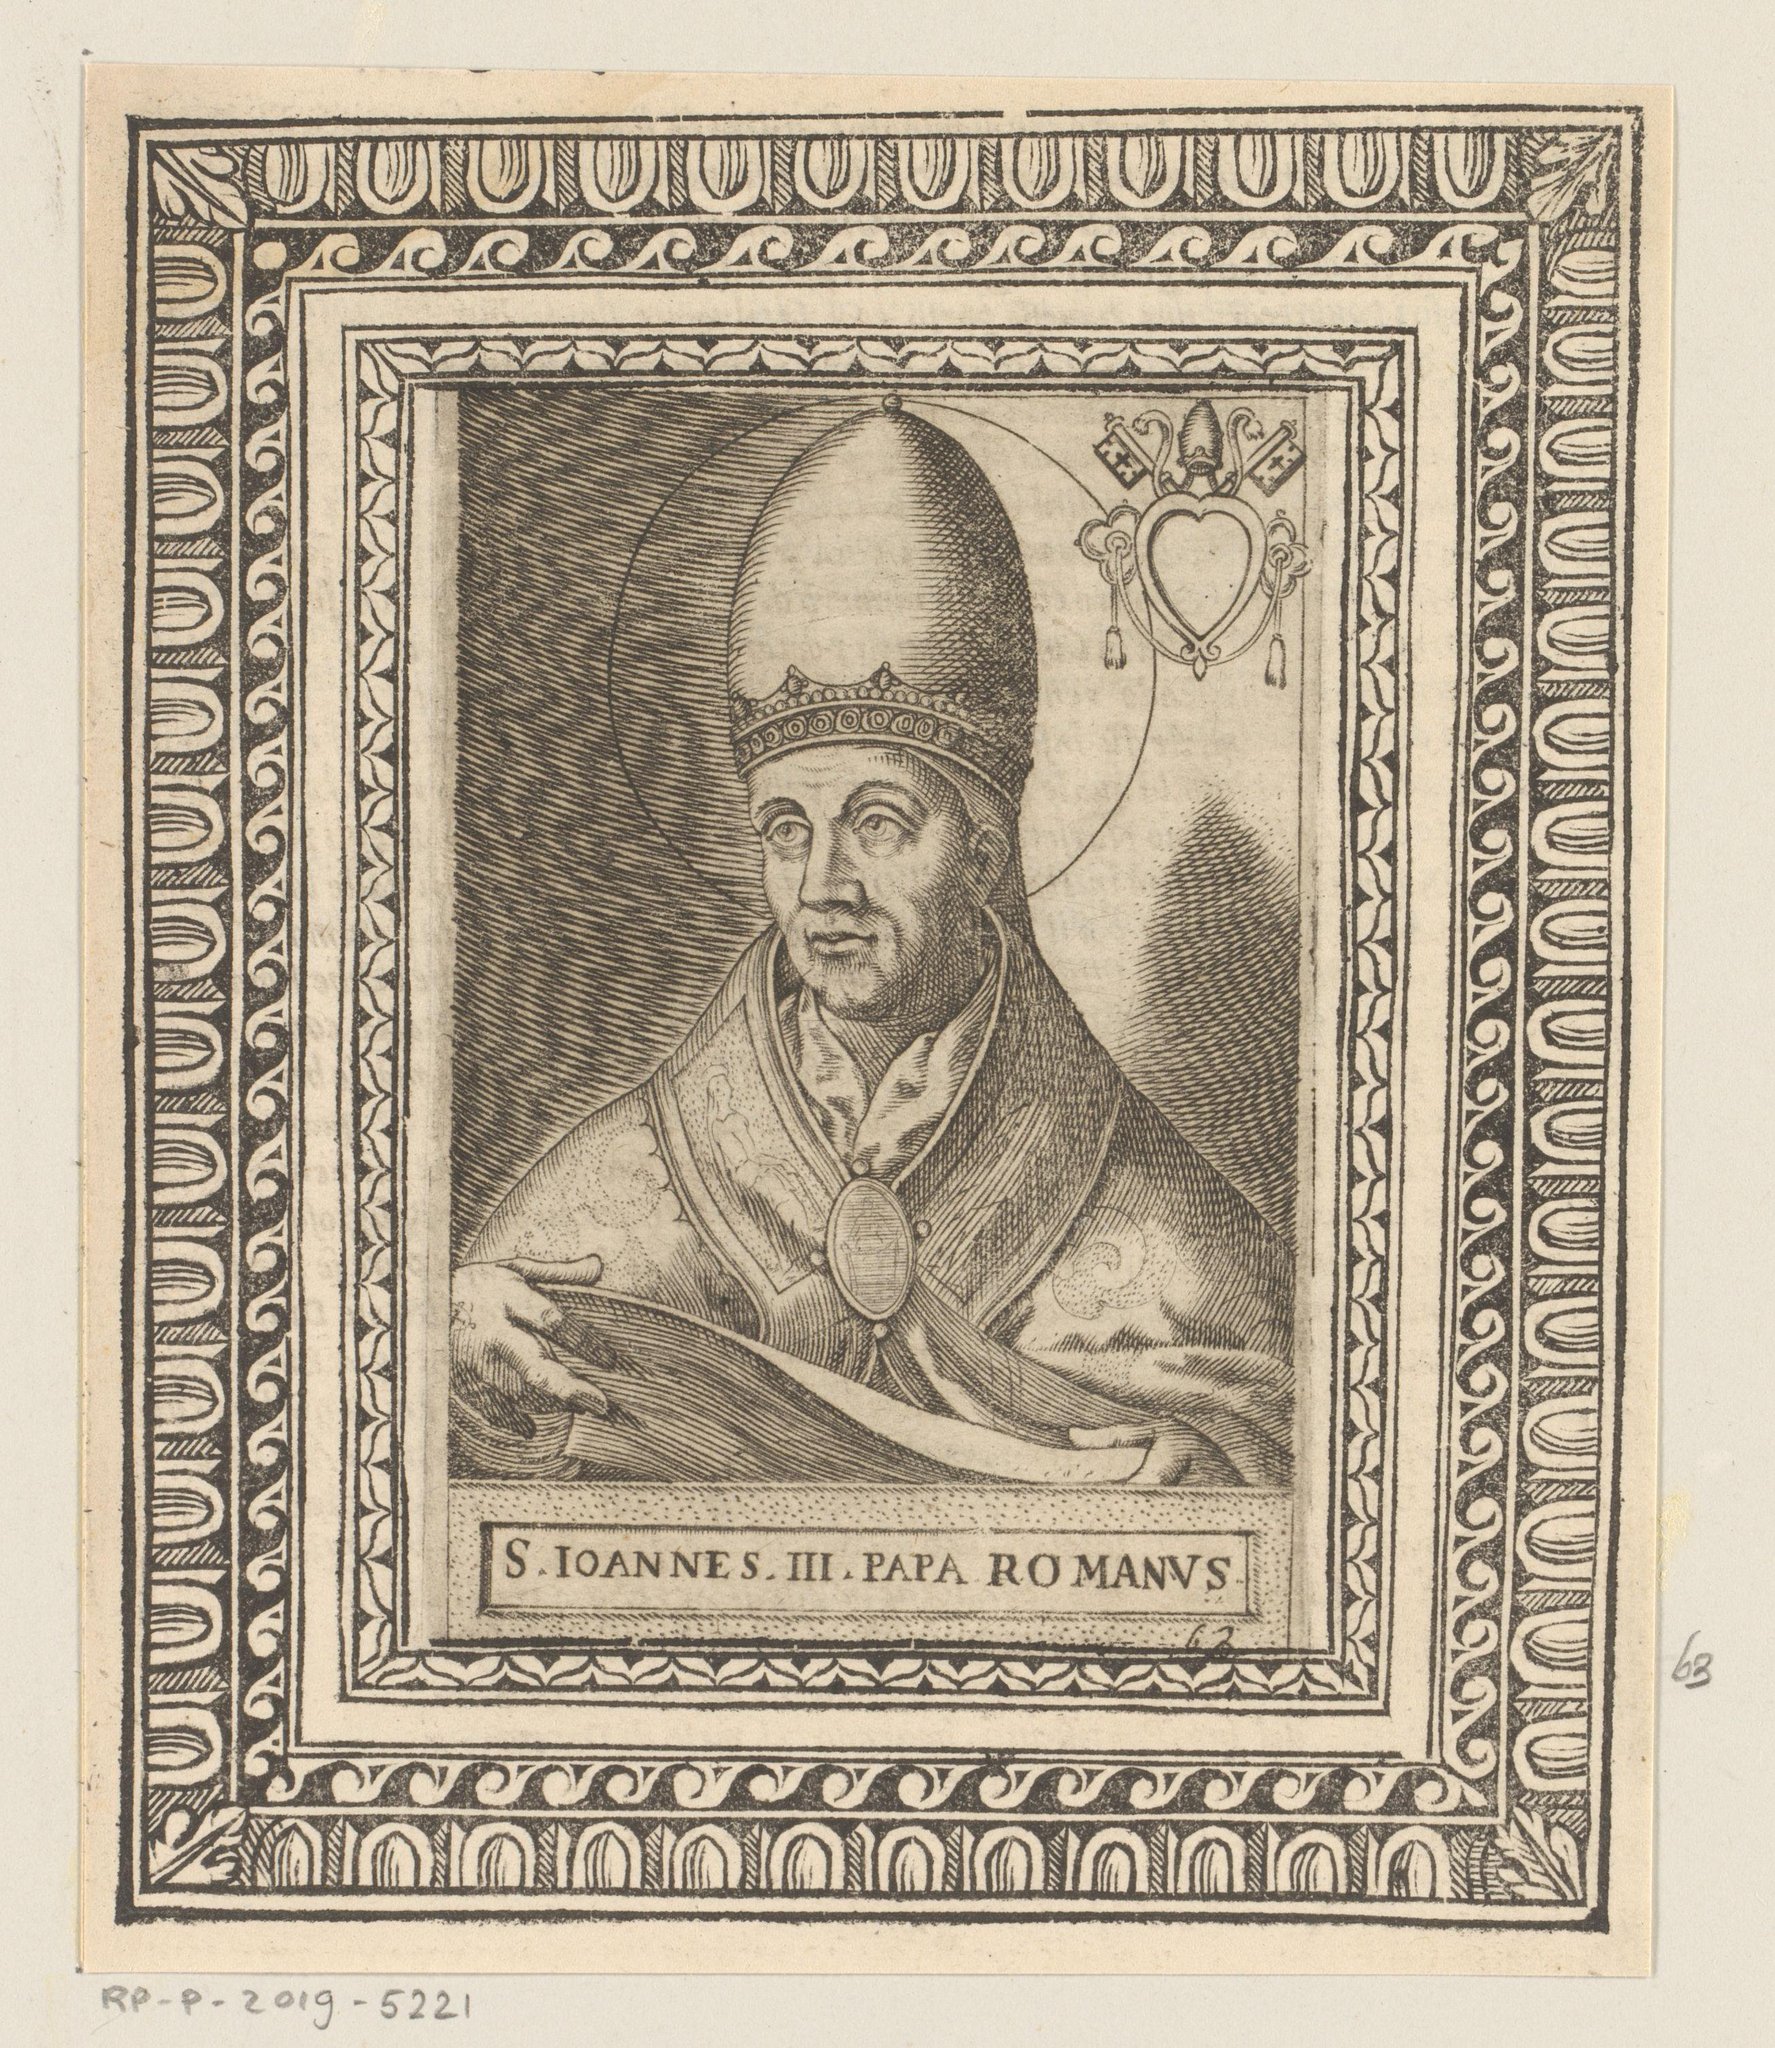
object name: book illustration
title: Portret van paus Johannes III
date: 1587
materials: paper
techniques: engraving, letterpress printing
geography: rome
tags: rome, historical persons, pope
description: Prent uit: Ciccarelli, Antonio. Le vite de Pontefici di Antonio Ciccarelli (...). Rome: Domenico Basa, 1587. Prent voor het eerst verschenen in: Cavalieri, Giovanni Battista de'. Pontificum romanorum effigies (...). Rome: Domenico Basa en Francesco Zanetti, 1580. Prent ook gebruikt in latere publicaties.